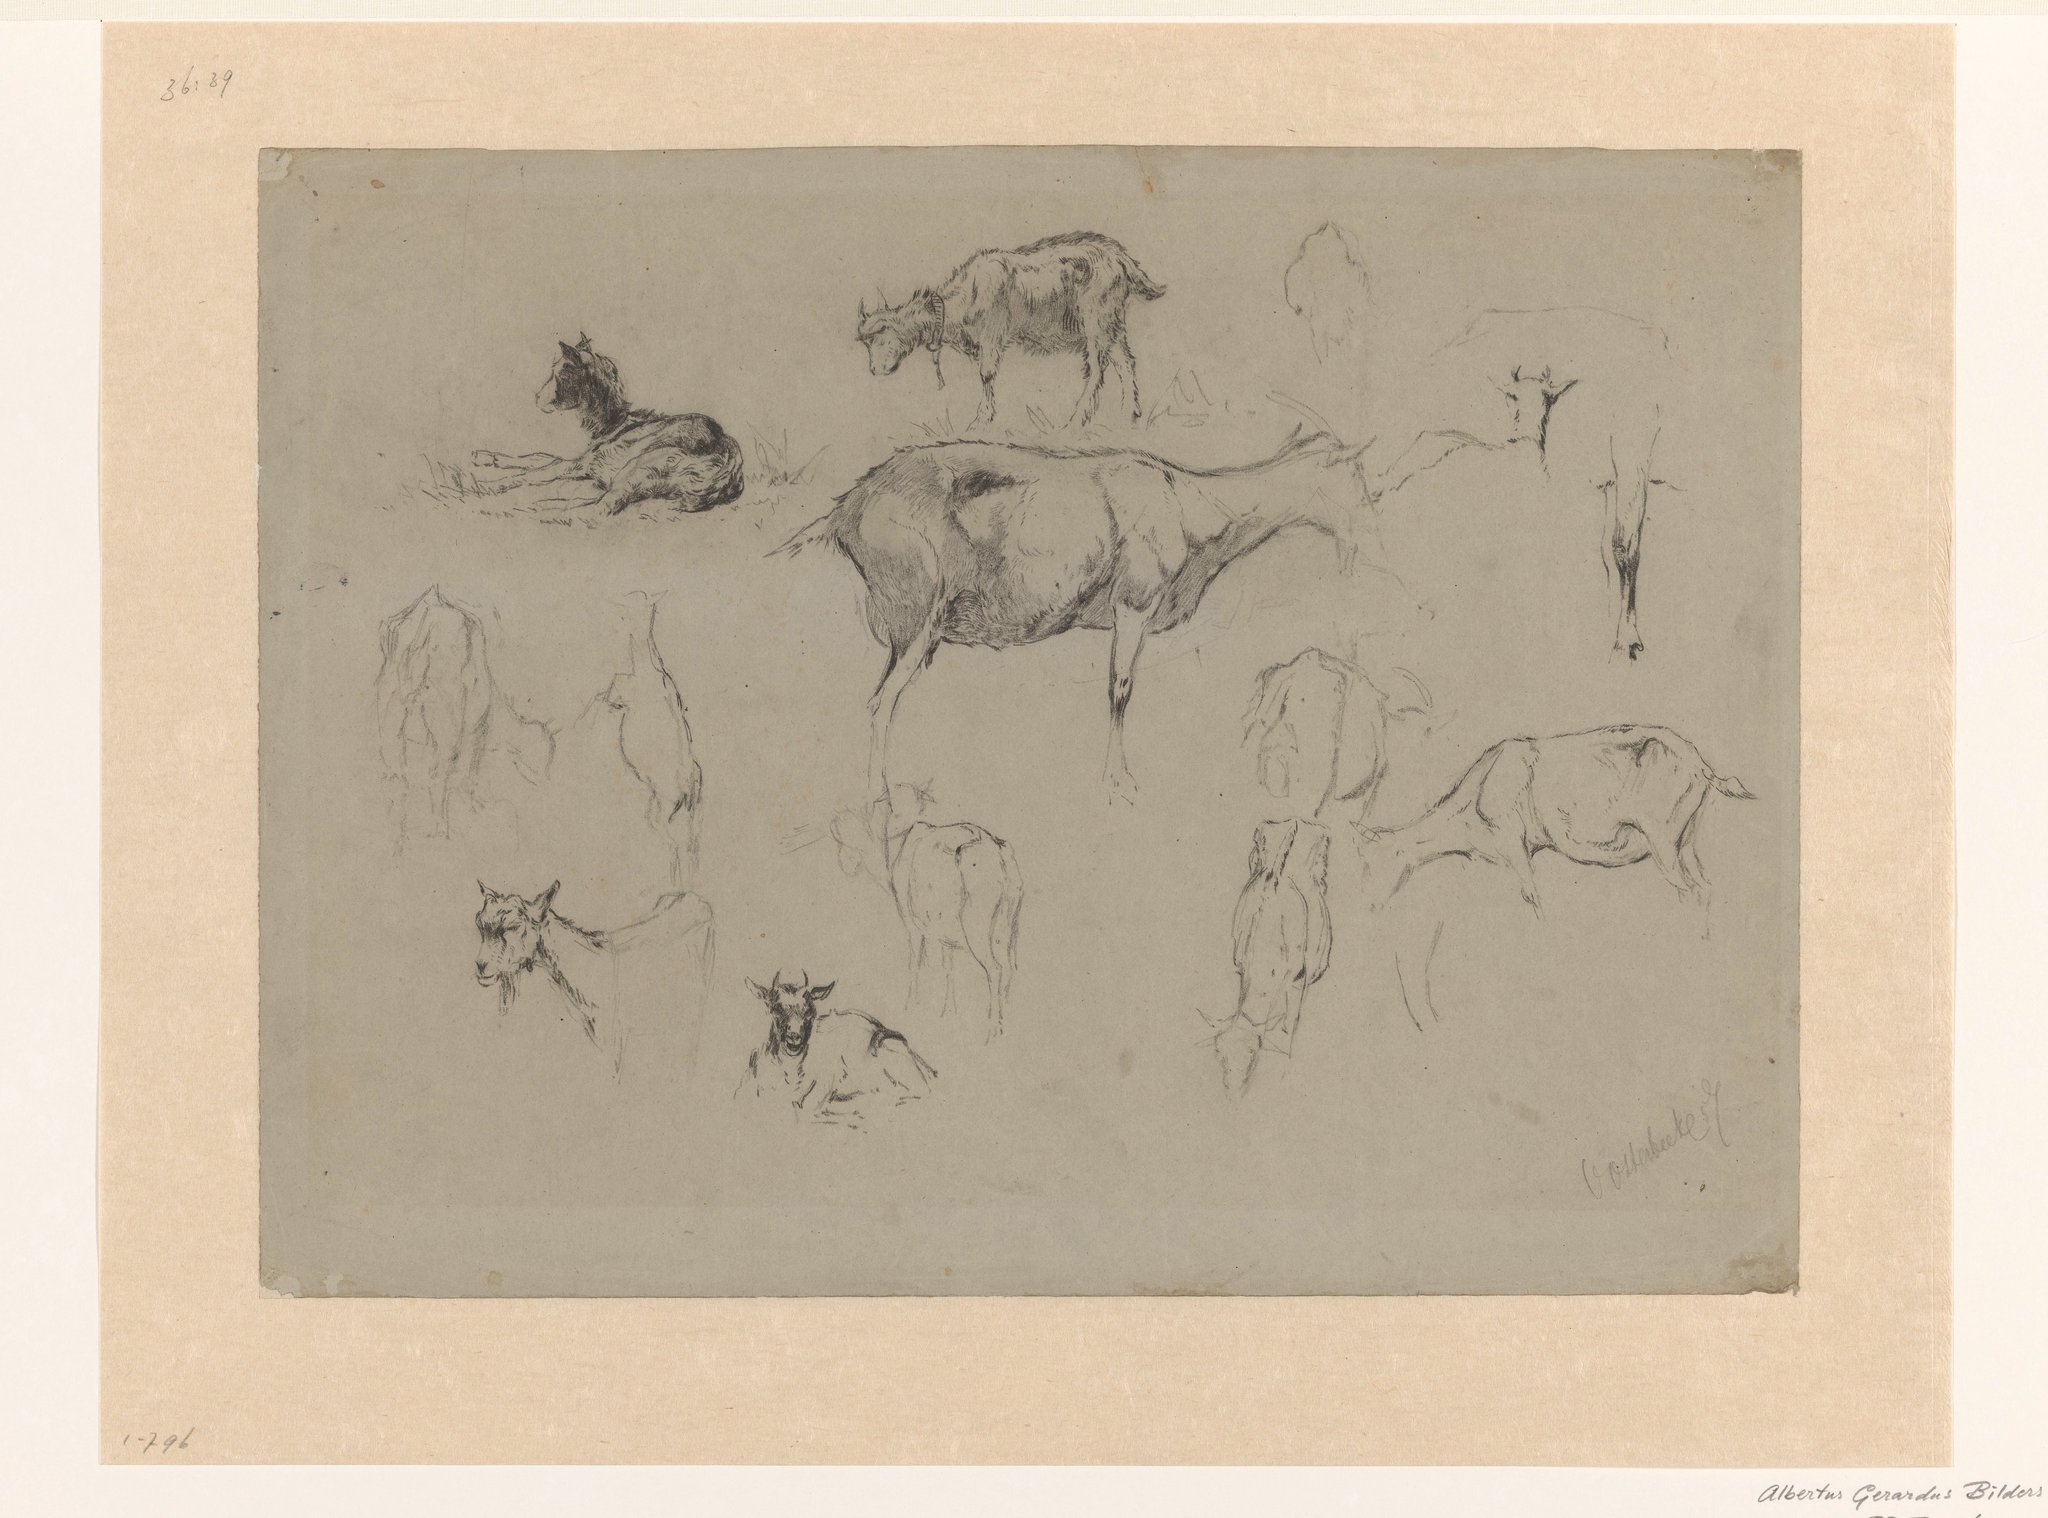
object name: drawing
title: Schetsblad met studies van geiten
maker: gerard bilders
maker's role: draughtsman, print maker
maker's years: 1838-1865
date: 1857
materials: chalk, paper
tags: goat